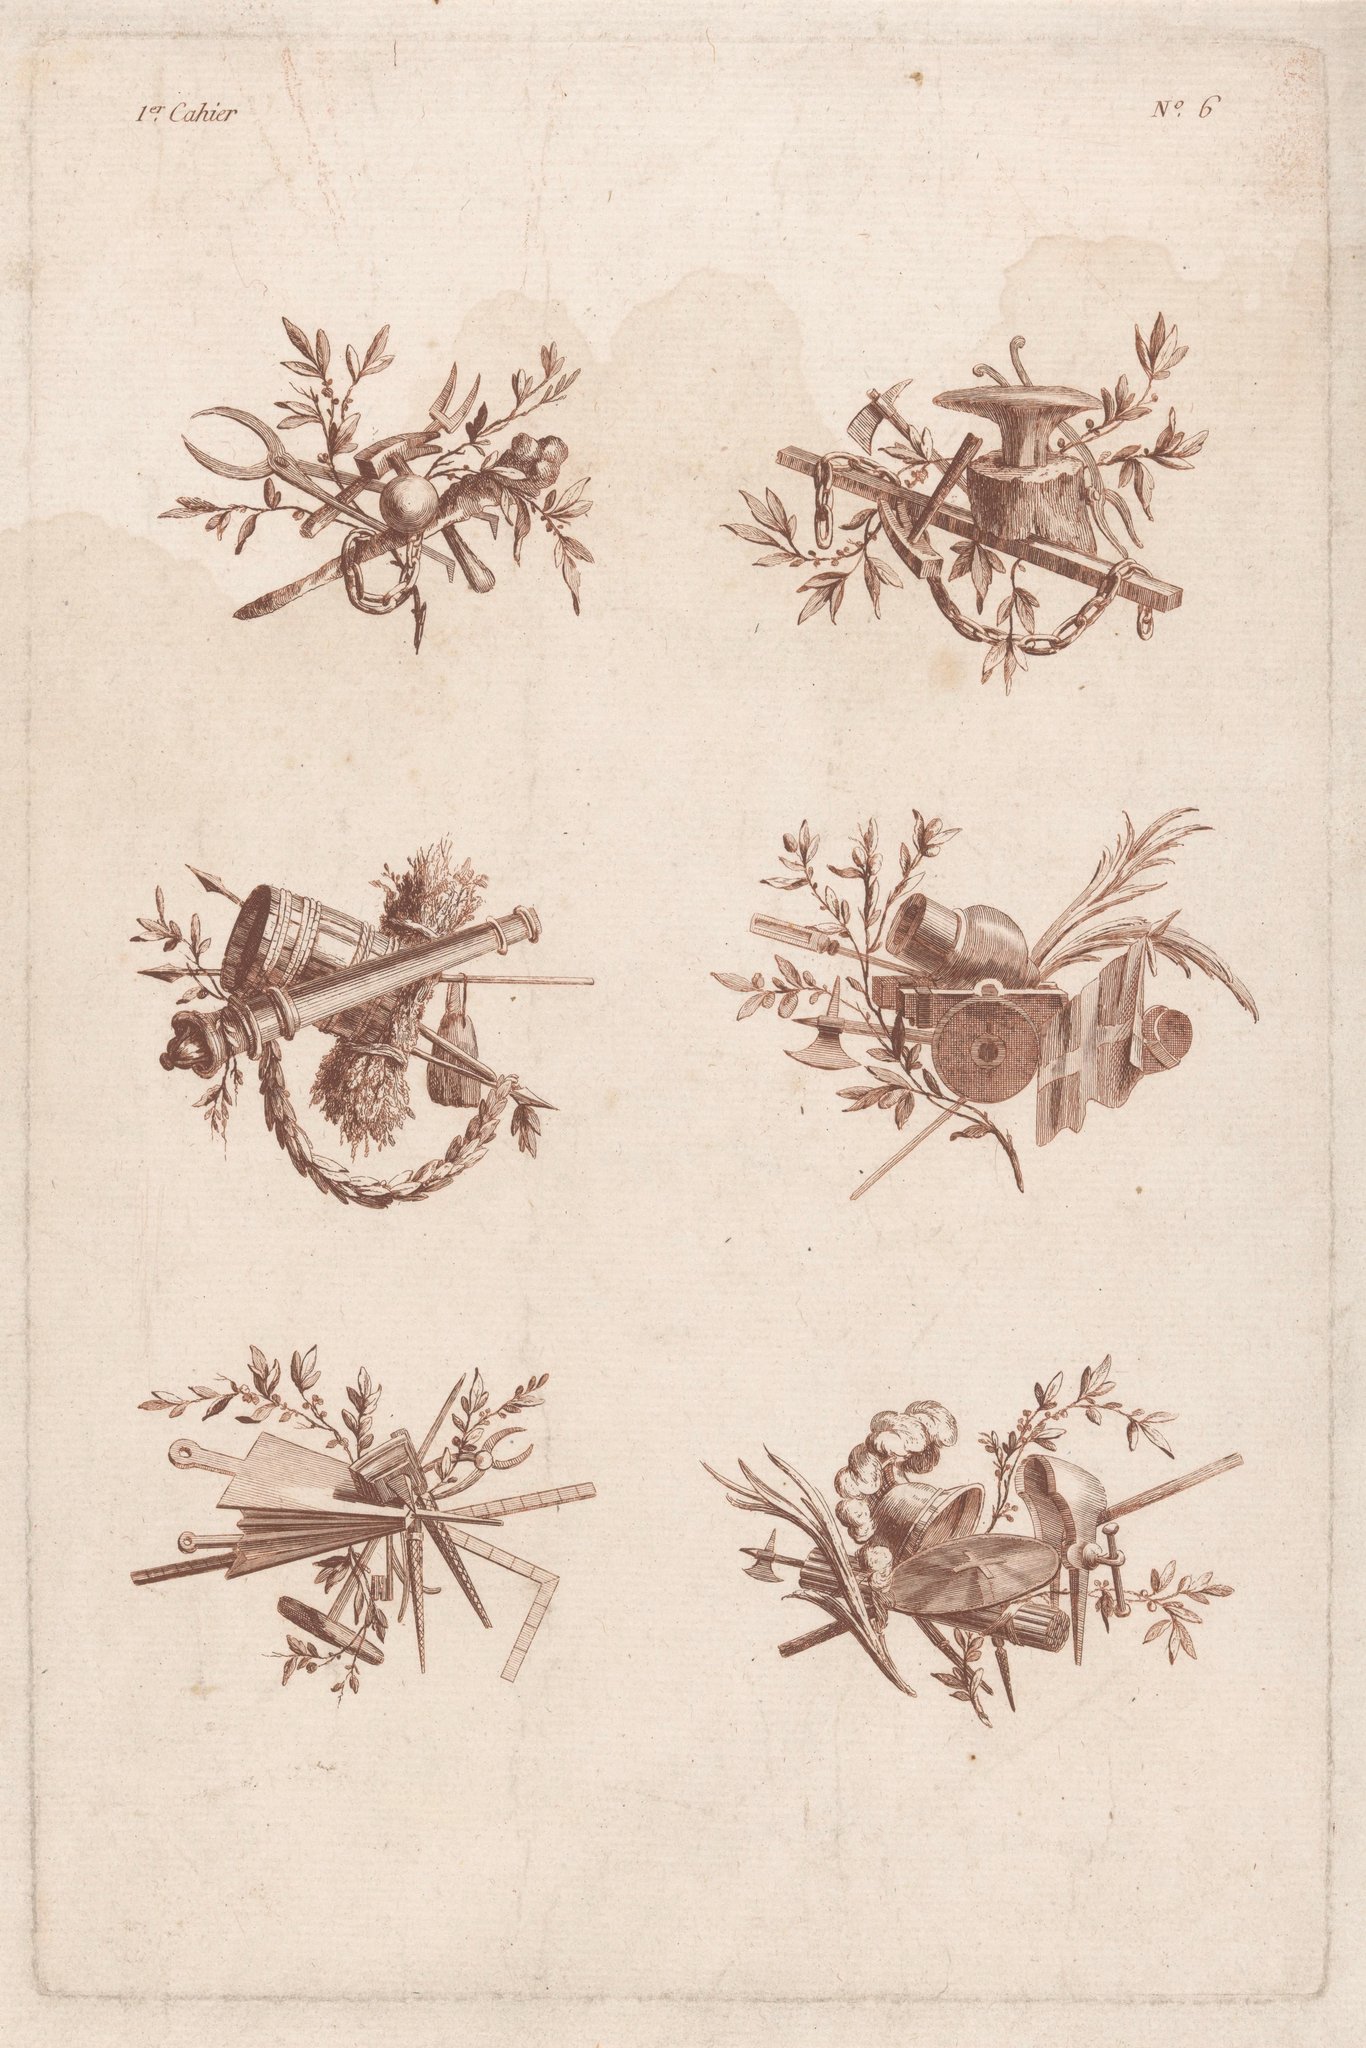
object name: print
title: Ier Cahier de Trophées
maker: pierre gabriel berthault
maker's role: print maker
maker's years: 1737-1819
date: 1772-1779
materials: paper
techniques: etching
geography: paris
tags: trophy, i.e.: decorative arrangement of symbolic or typical objects ~ ornament, forging (industrial process)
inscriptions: collector's mark: Lugt 2228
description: Zes trofeeën met attributen behorend bij smeedkunst zoals een tang, hamers, een kettingkogel, een aambeeld, kanonnen, speren, wapens, een blaasbalg, meetinstrumenten, een schild en een helm.